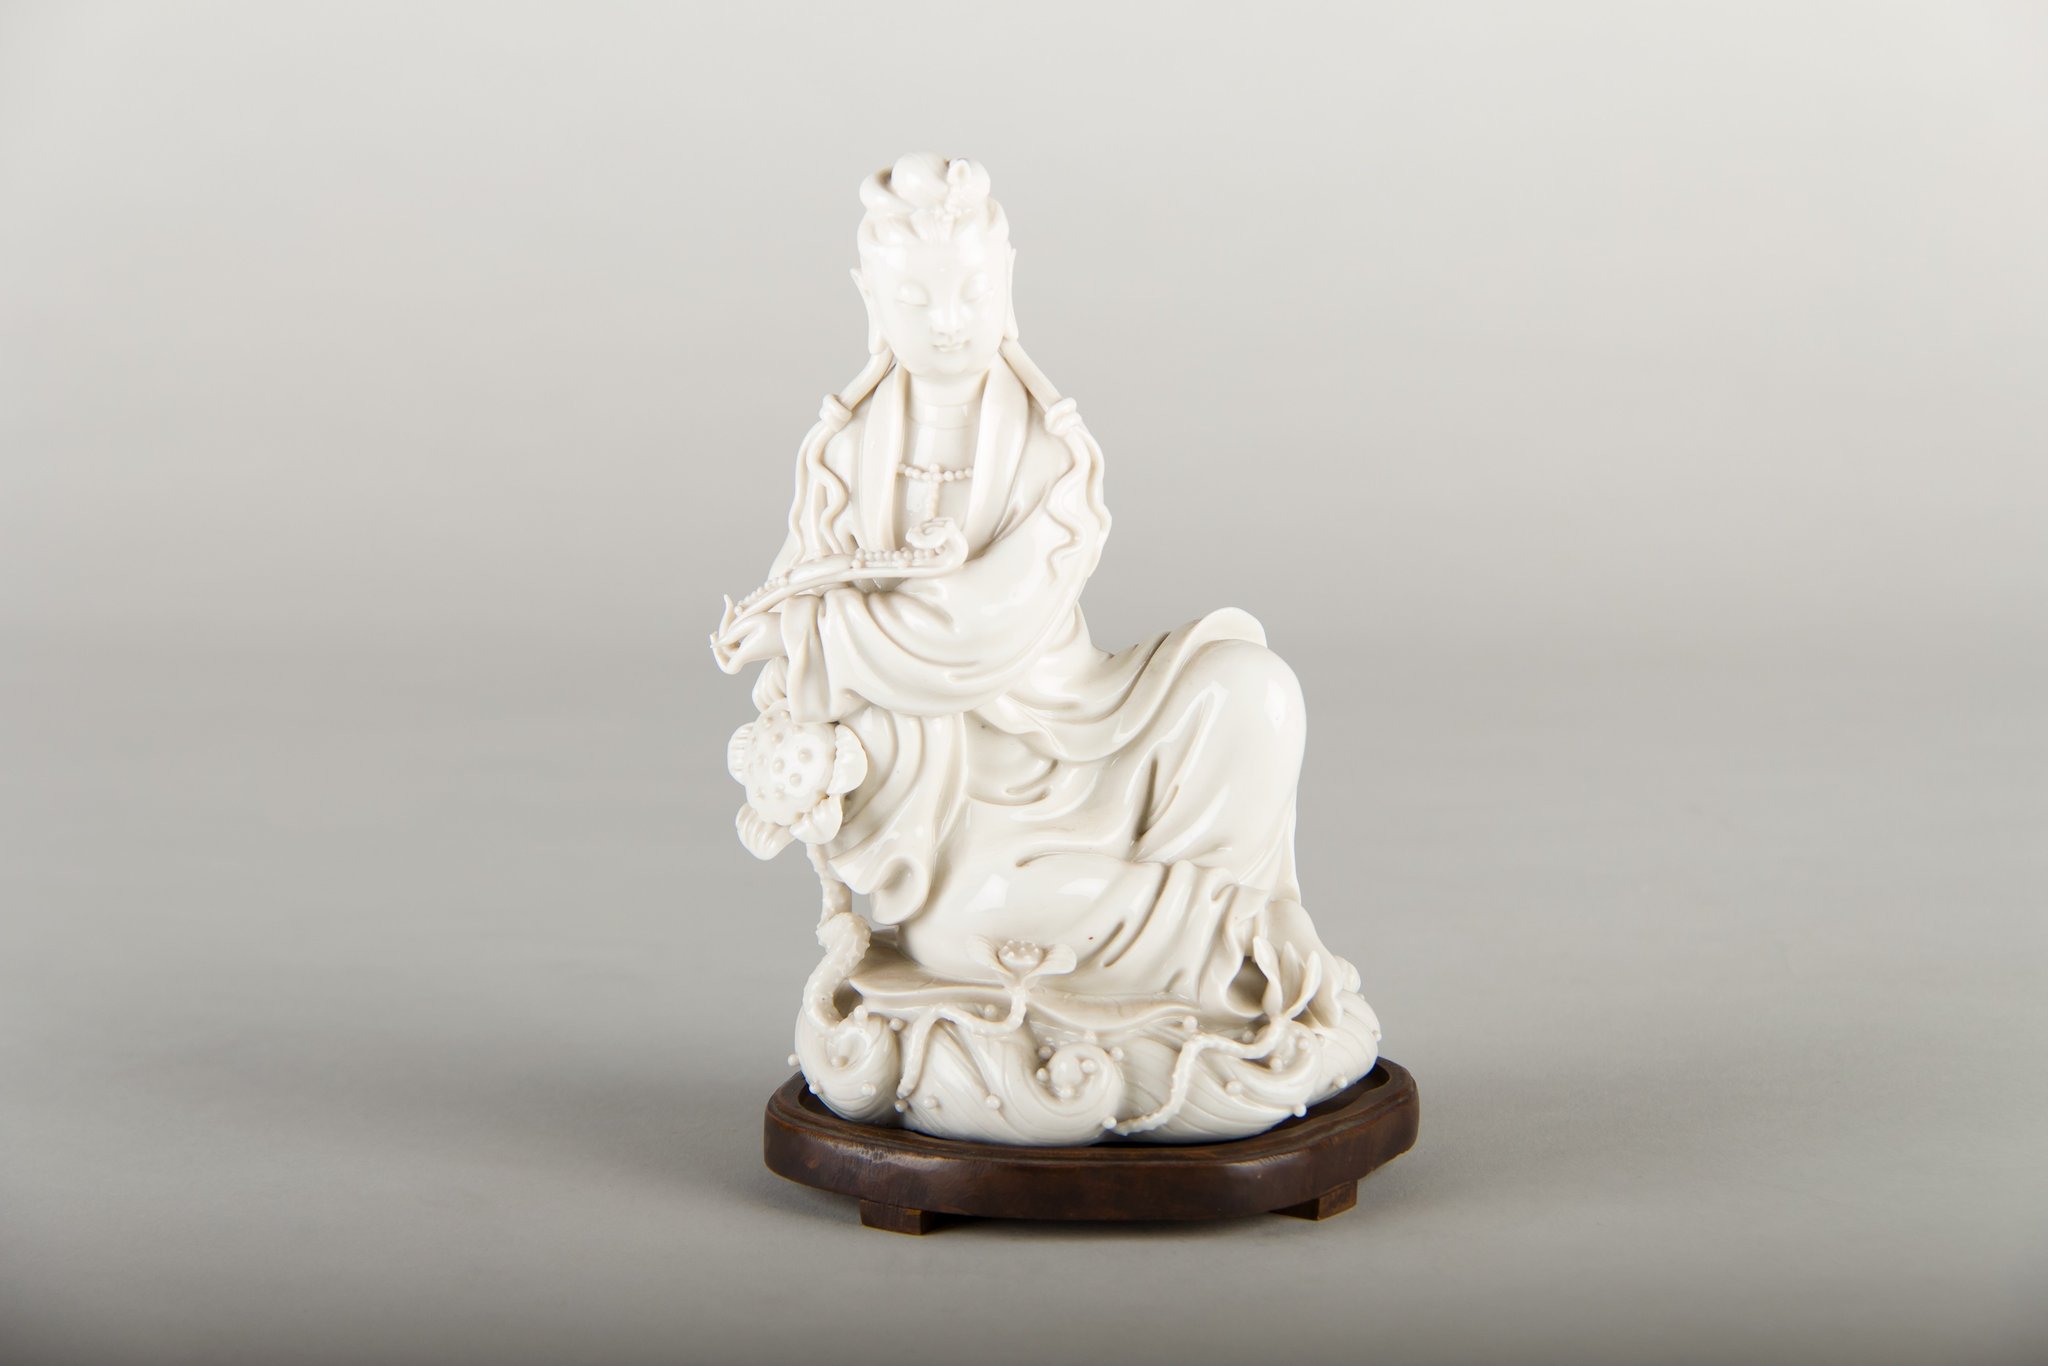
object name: figure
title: Figure of bodhisattva Guanyin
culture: chinese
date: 1701-1900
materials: glaze, ivory, porcelain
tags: buddhism,bodhisattvas